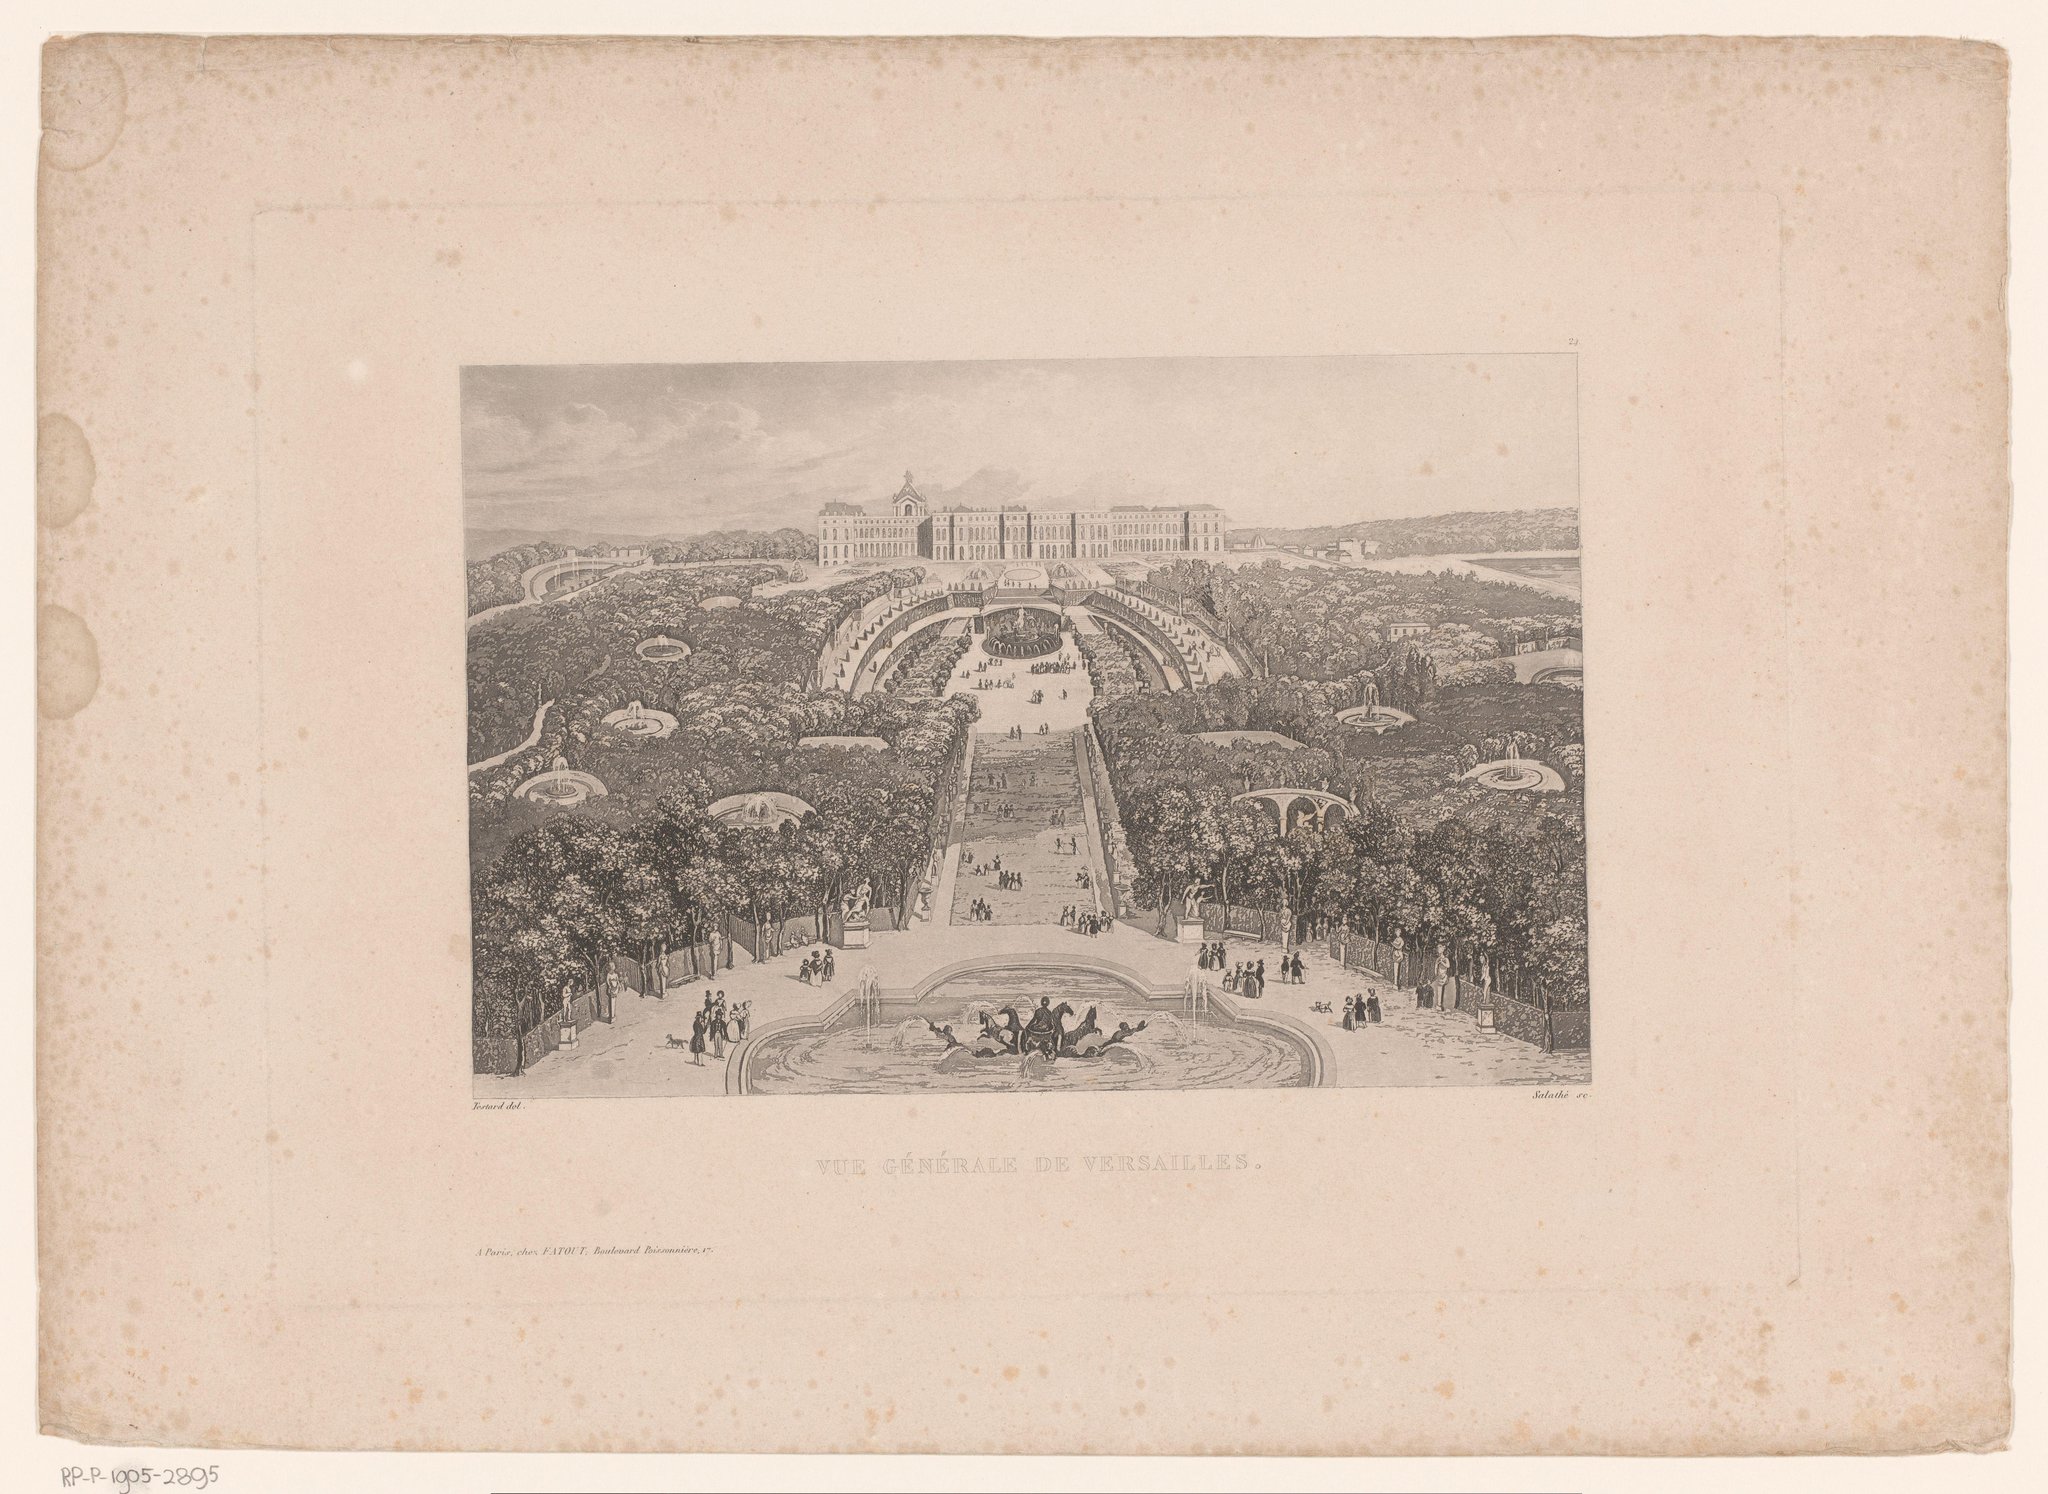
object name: print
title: Vue générale de Versailles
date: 1803-1858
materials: paper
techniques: aquatint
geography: paris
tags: landscape with tower or castle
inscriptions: collector's mark: Lugt 2228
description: Prent maakt deel uit van een verder onbekende genummerde serie.